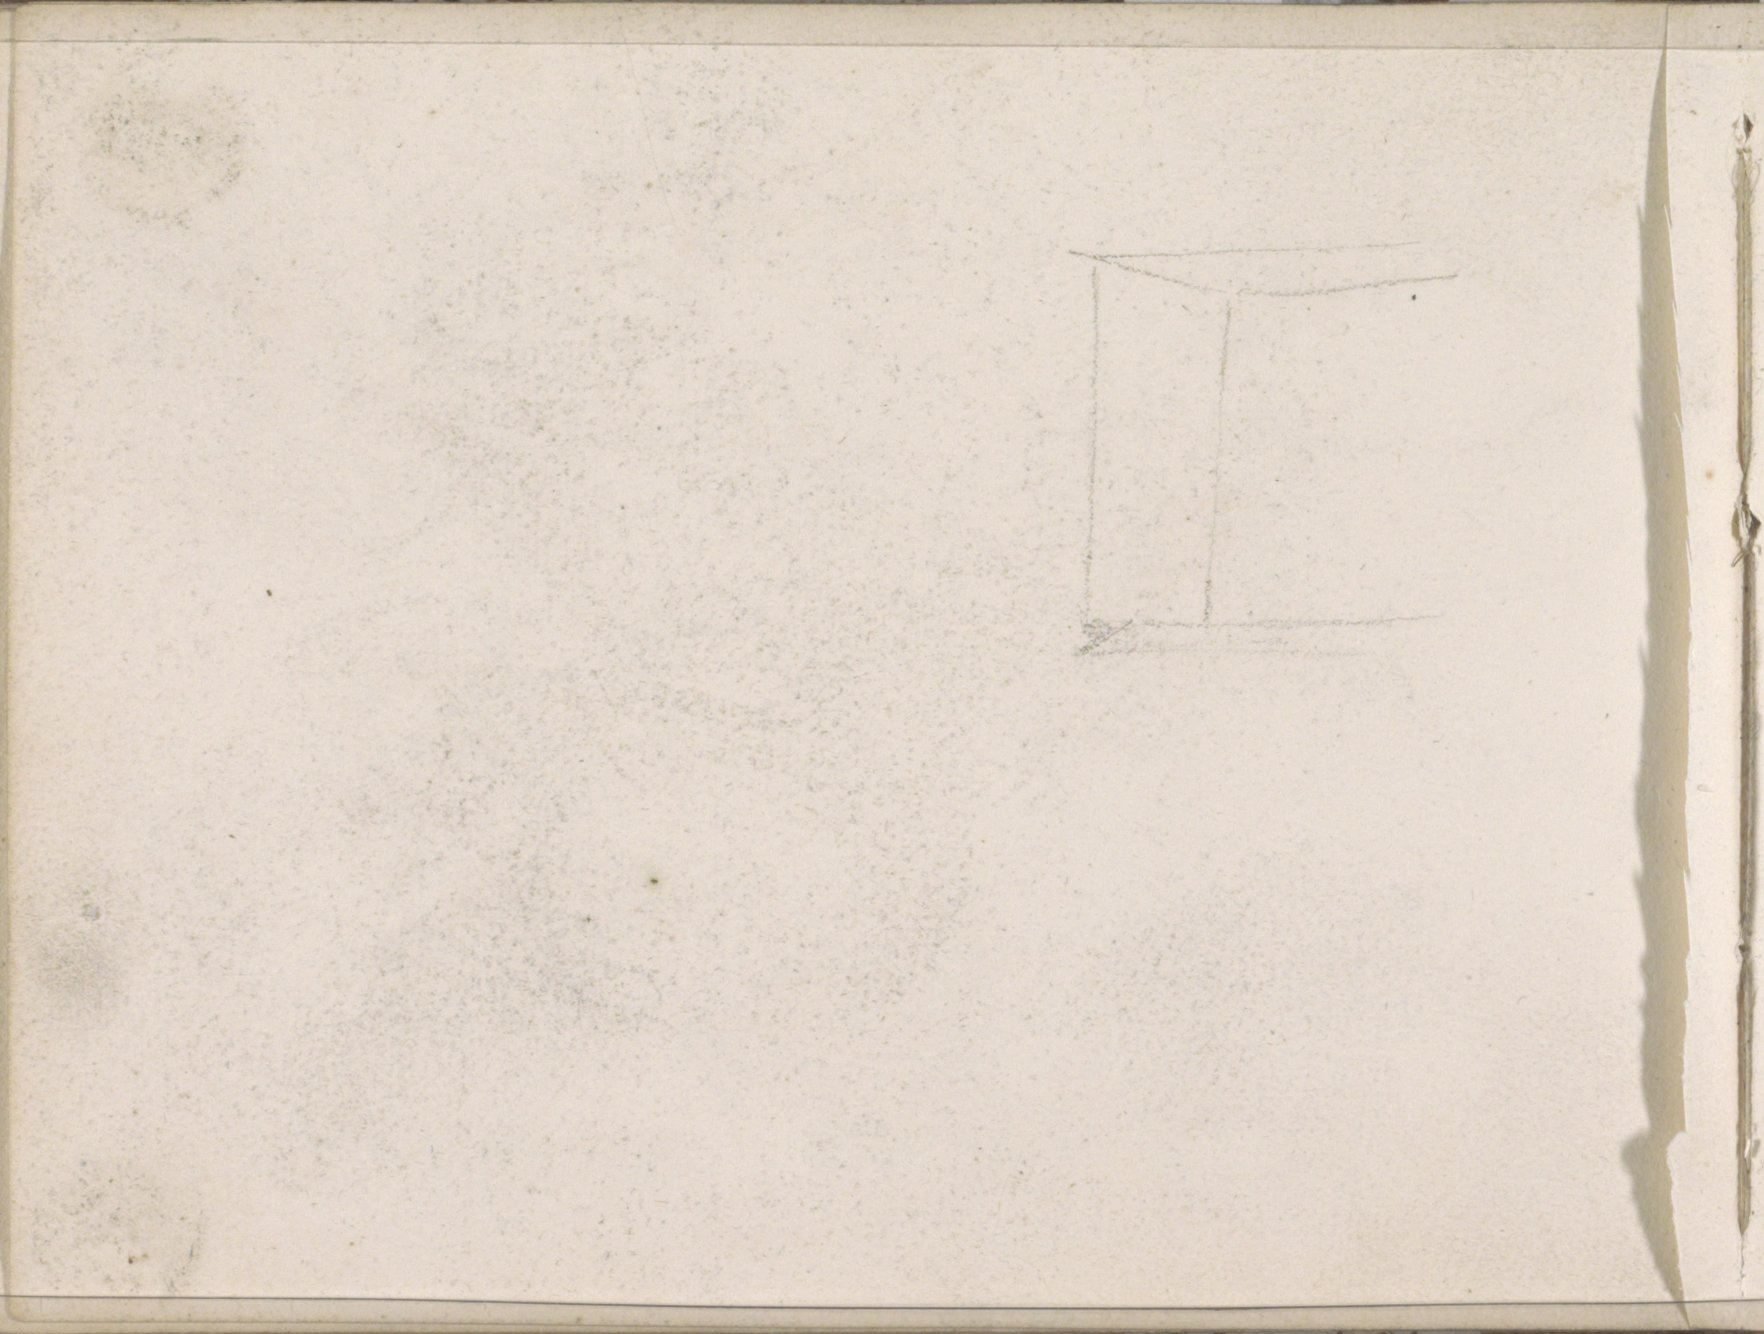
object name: sketchbook leaf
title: Studie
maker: maria vos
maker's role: draughtsman, painter, print maker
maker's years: 1824-1906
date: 1834-1906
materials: paper, pencil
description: Blad 18 verso uit een schetsboek met 21 bladen.